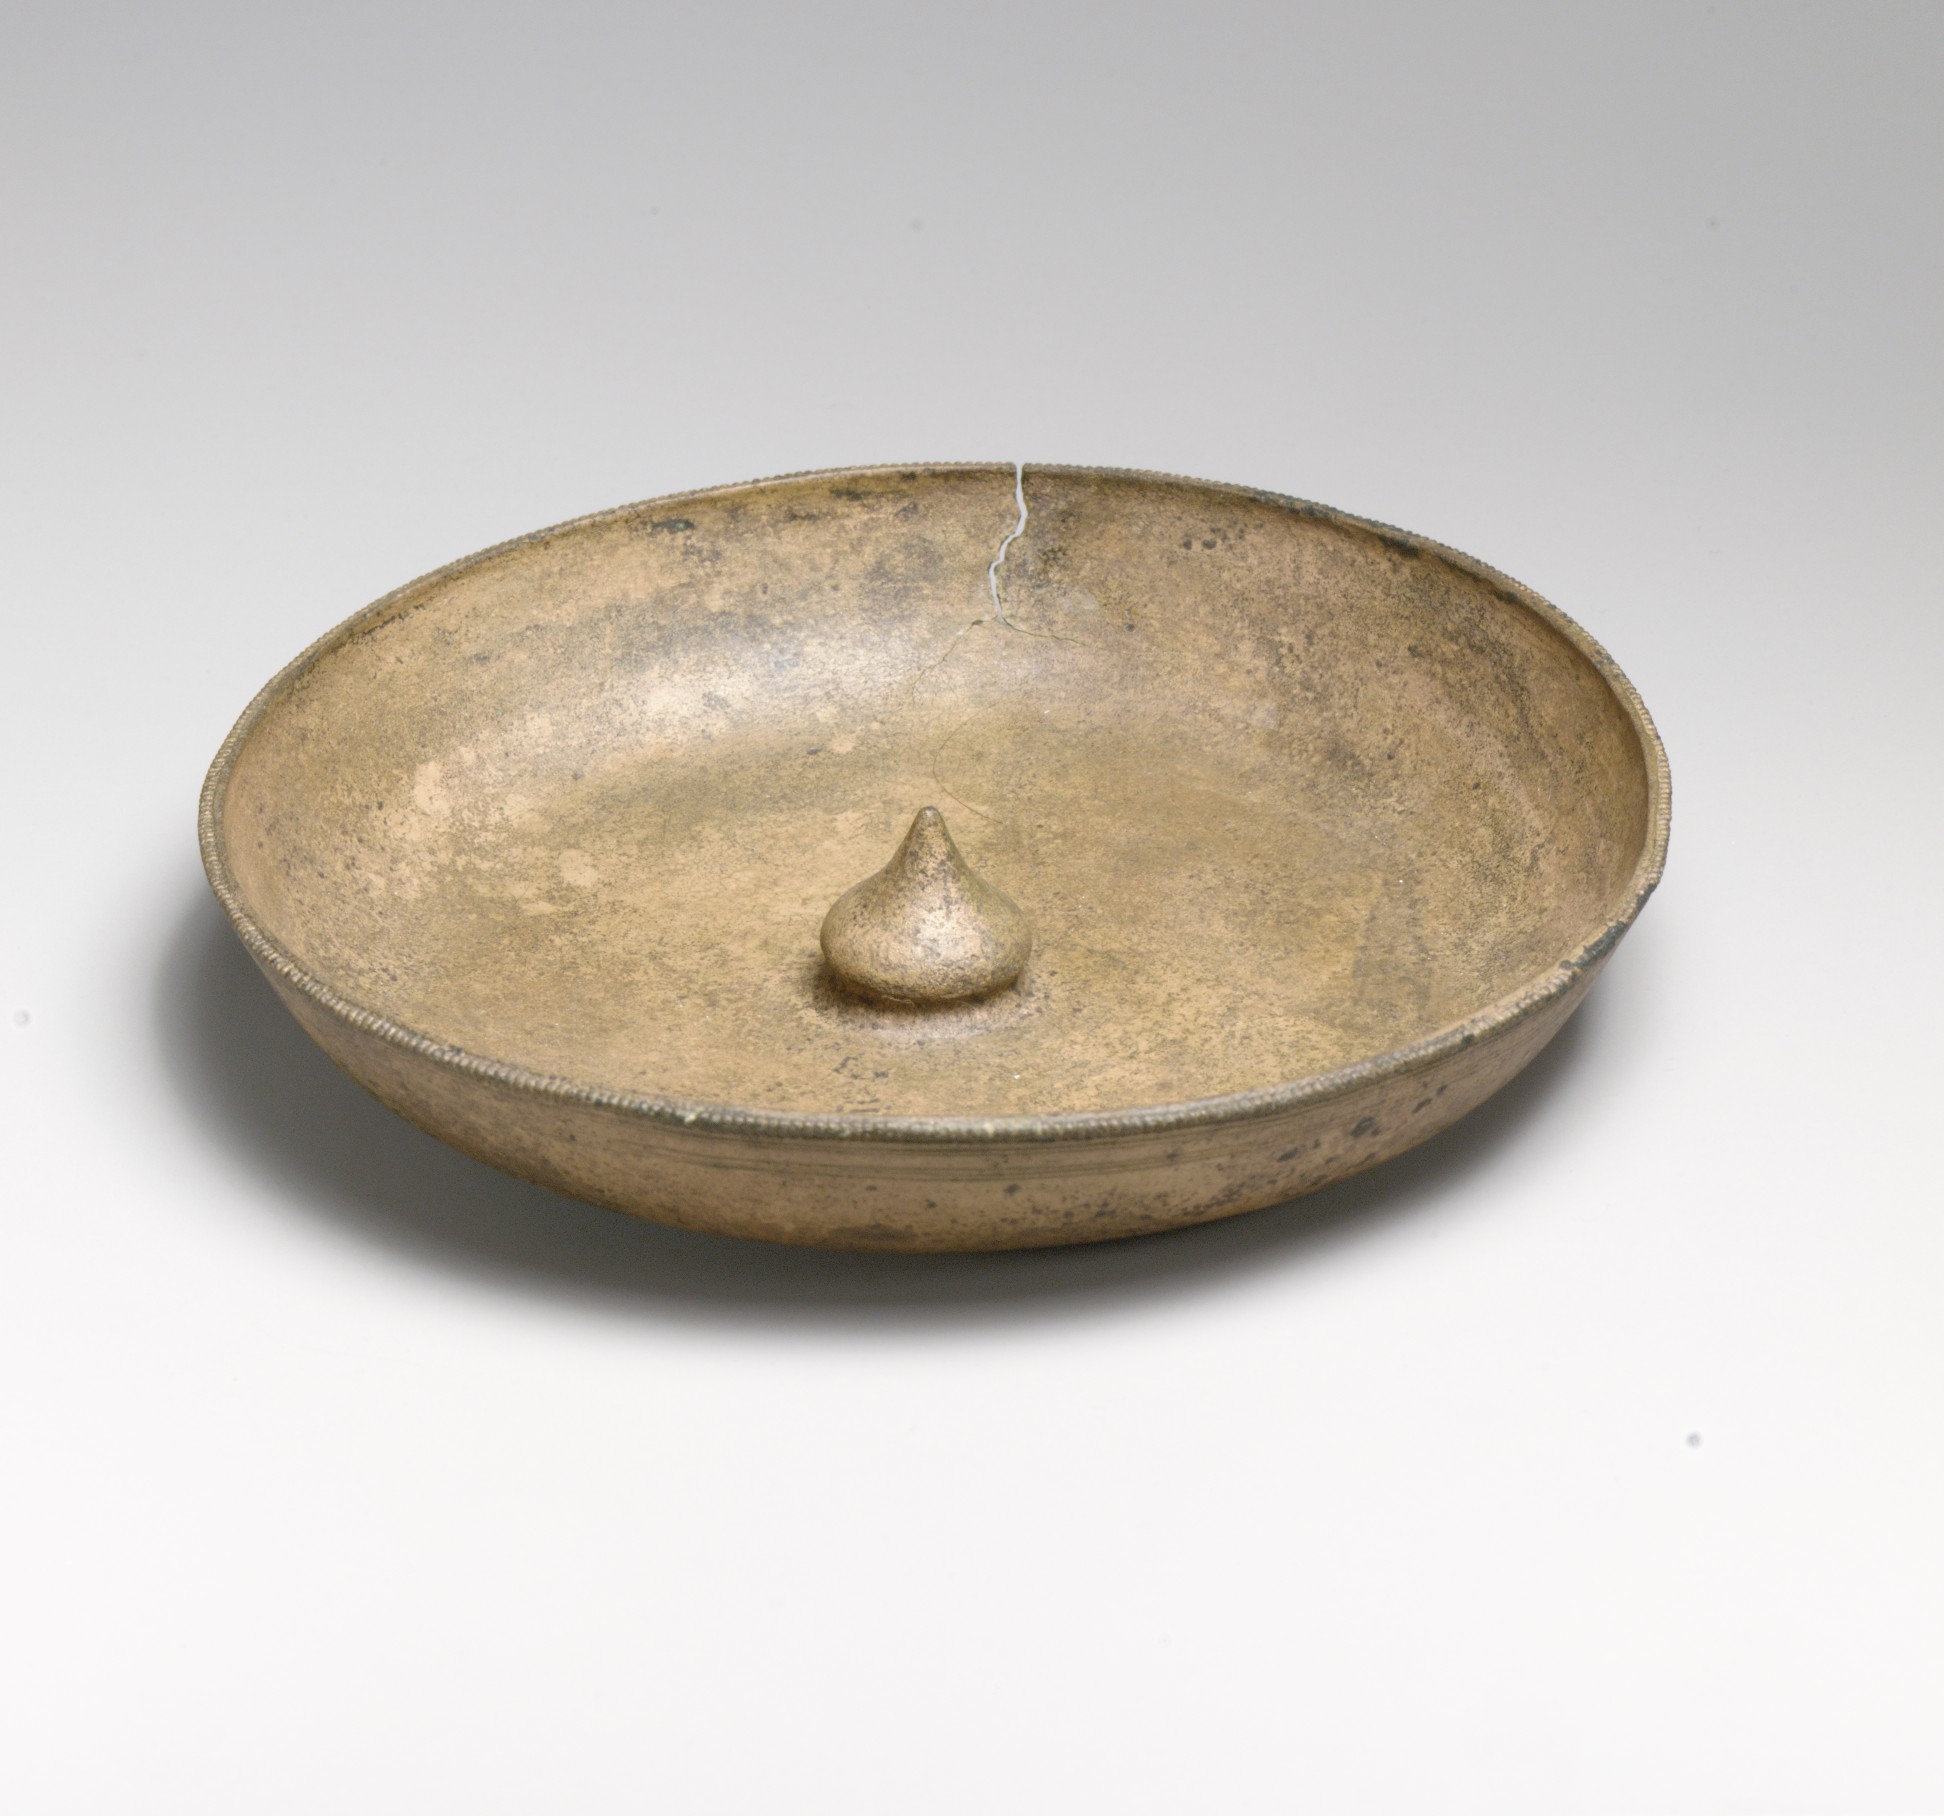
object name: bowl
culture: etruscan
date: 900-100 BCE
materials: bronze